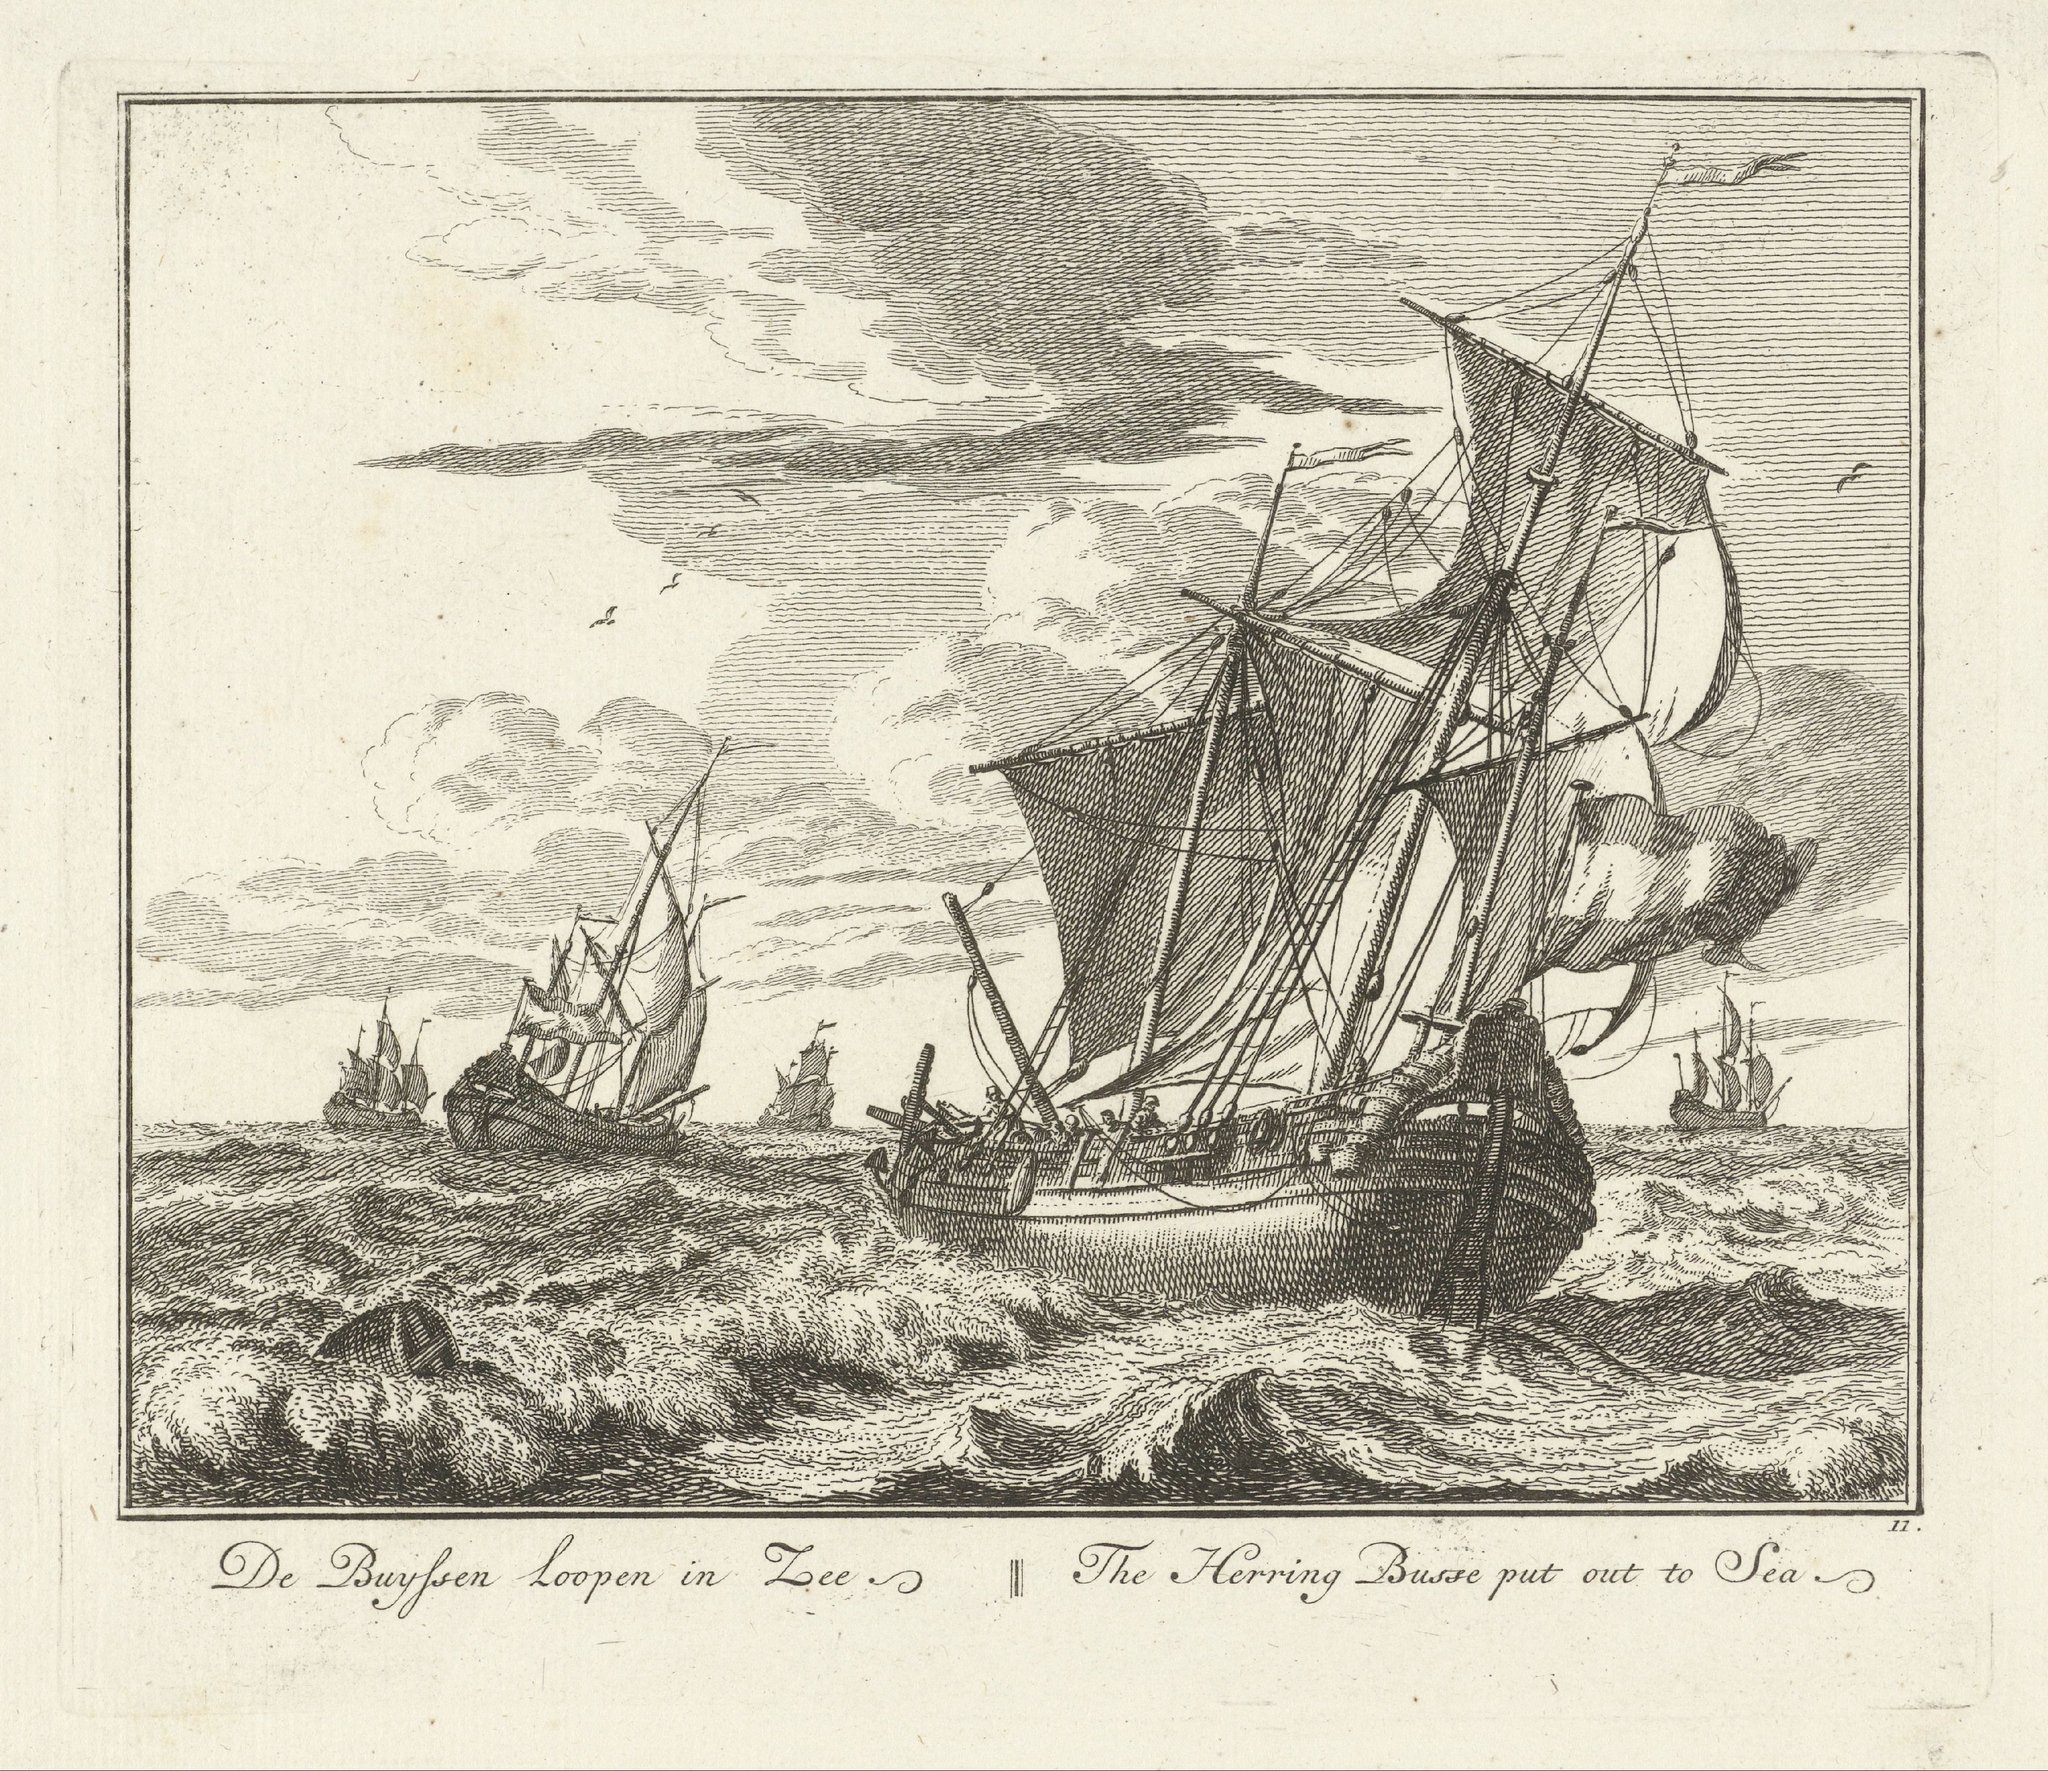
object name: print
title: Groote Vissery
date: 1728-1761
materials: paper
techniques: etching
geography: amsterdam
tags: bony fishes: herring, sea and coastal fishery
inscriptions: collector's mark: Lugt 2228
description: Een haringbuis zeilt de zee op om te vissen, op de achtergrond meer zeilschepen. De prent maakt deel uit van een 32-delige serie prenten met voorstellingen over de haringvangst.